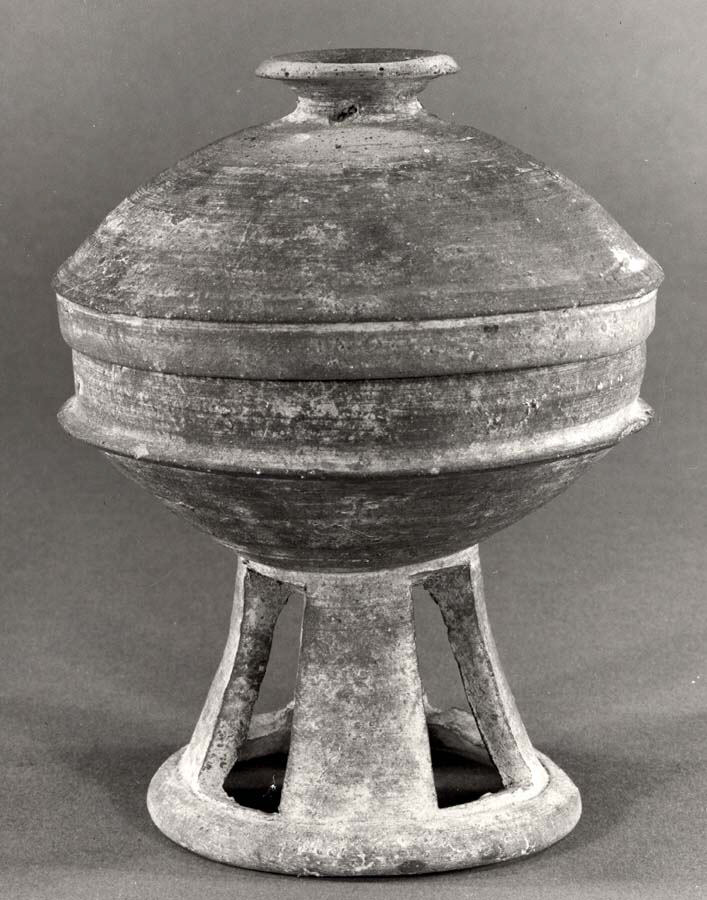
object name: dish with cover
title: Pedestal dish with cover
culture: korean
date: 57 BCE-688 CE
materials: stoneware